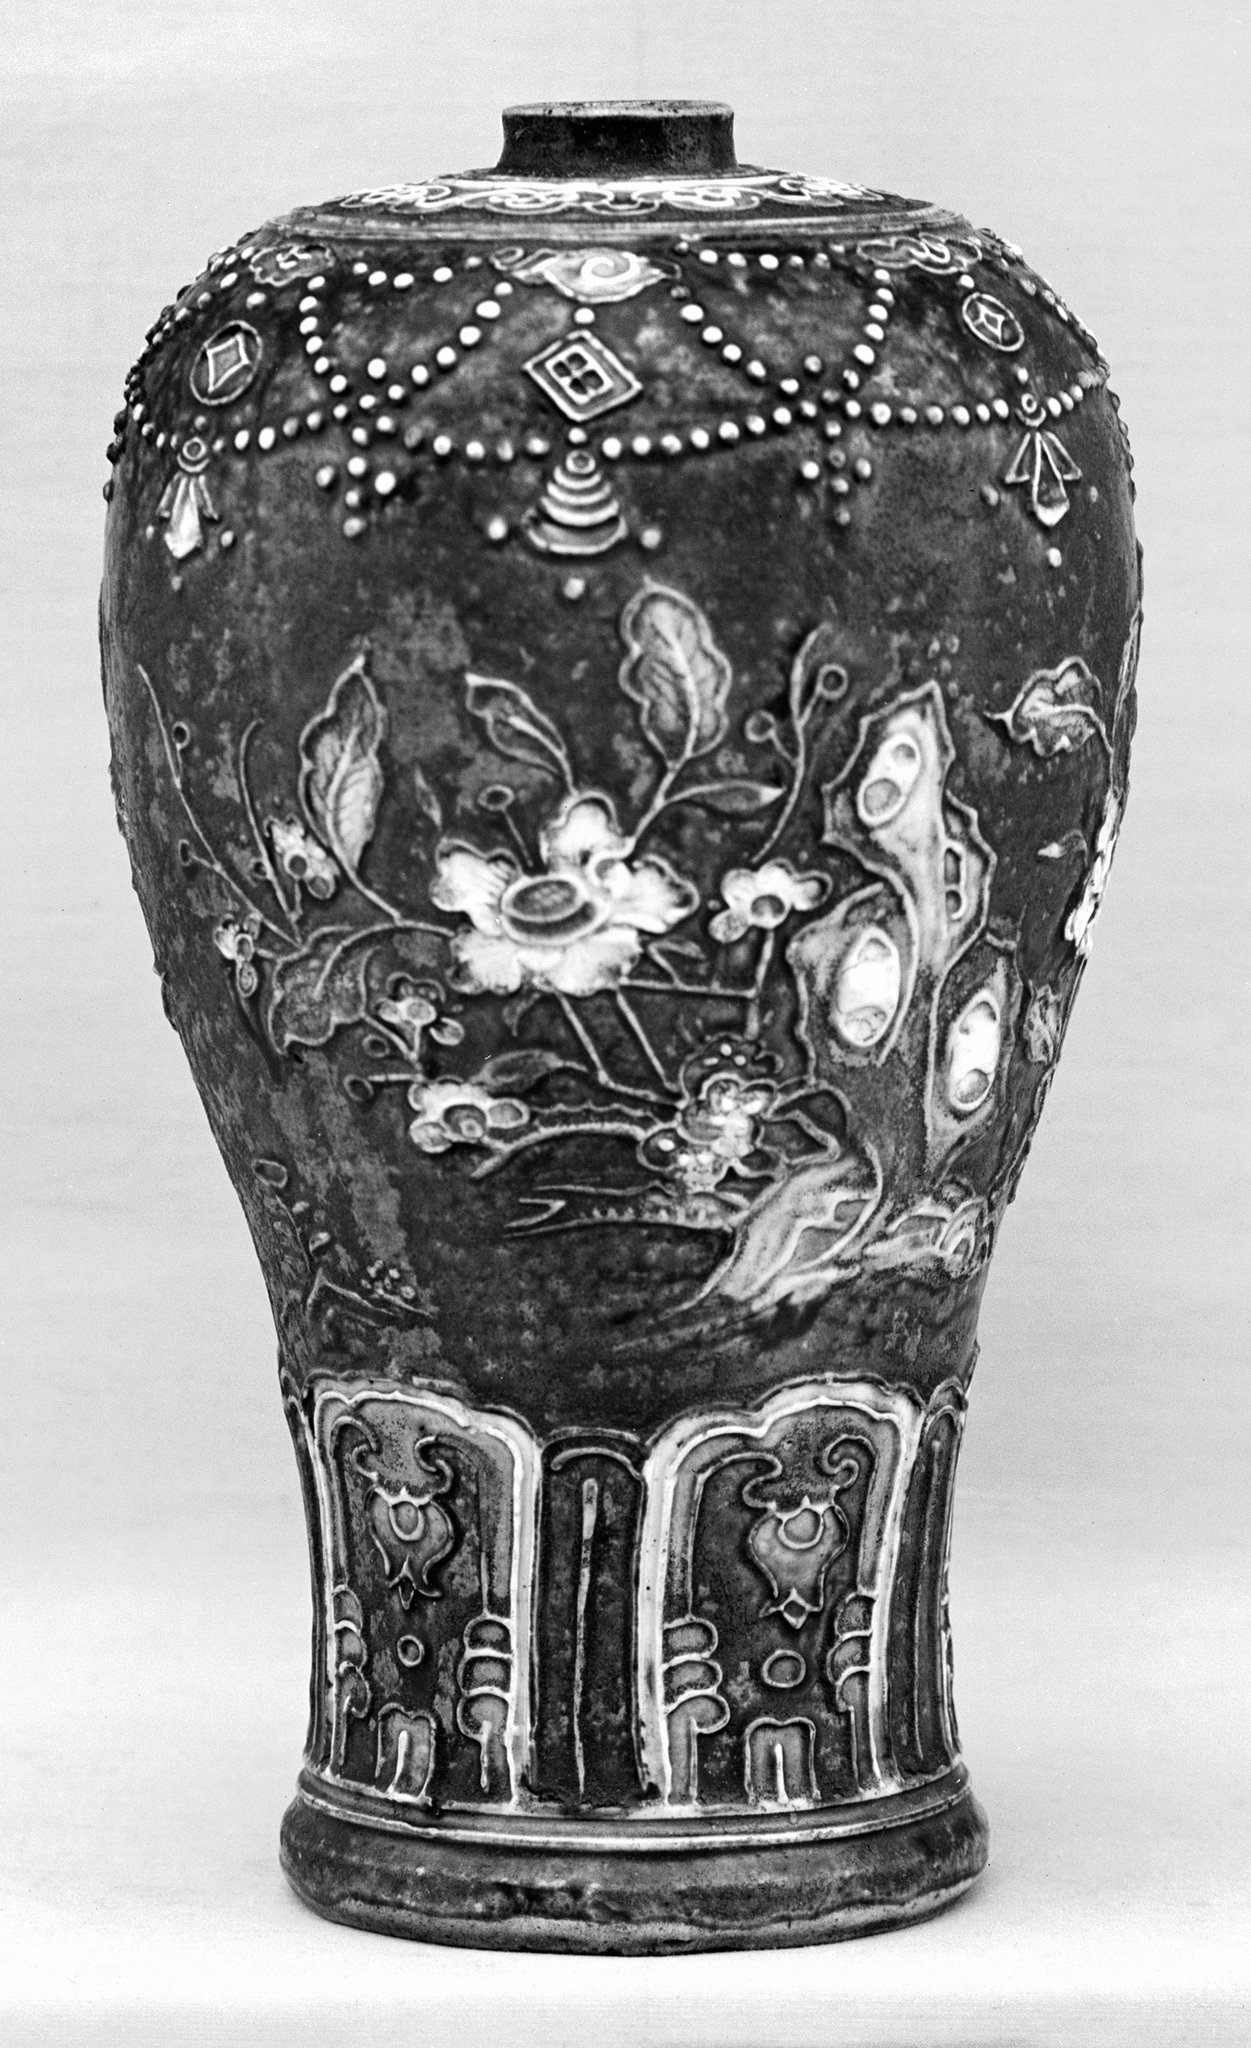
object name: vase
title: Meiping vase with flowers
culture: chinese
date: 1501-1533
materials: enamel, porcelain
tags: flowers